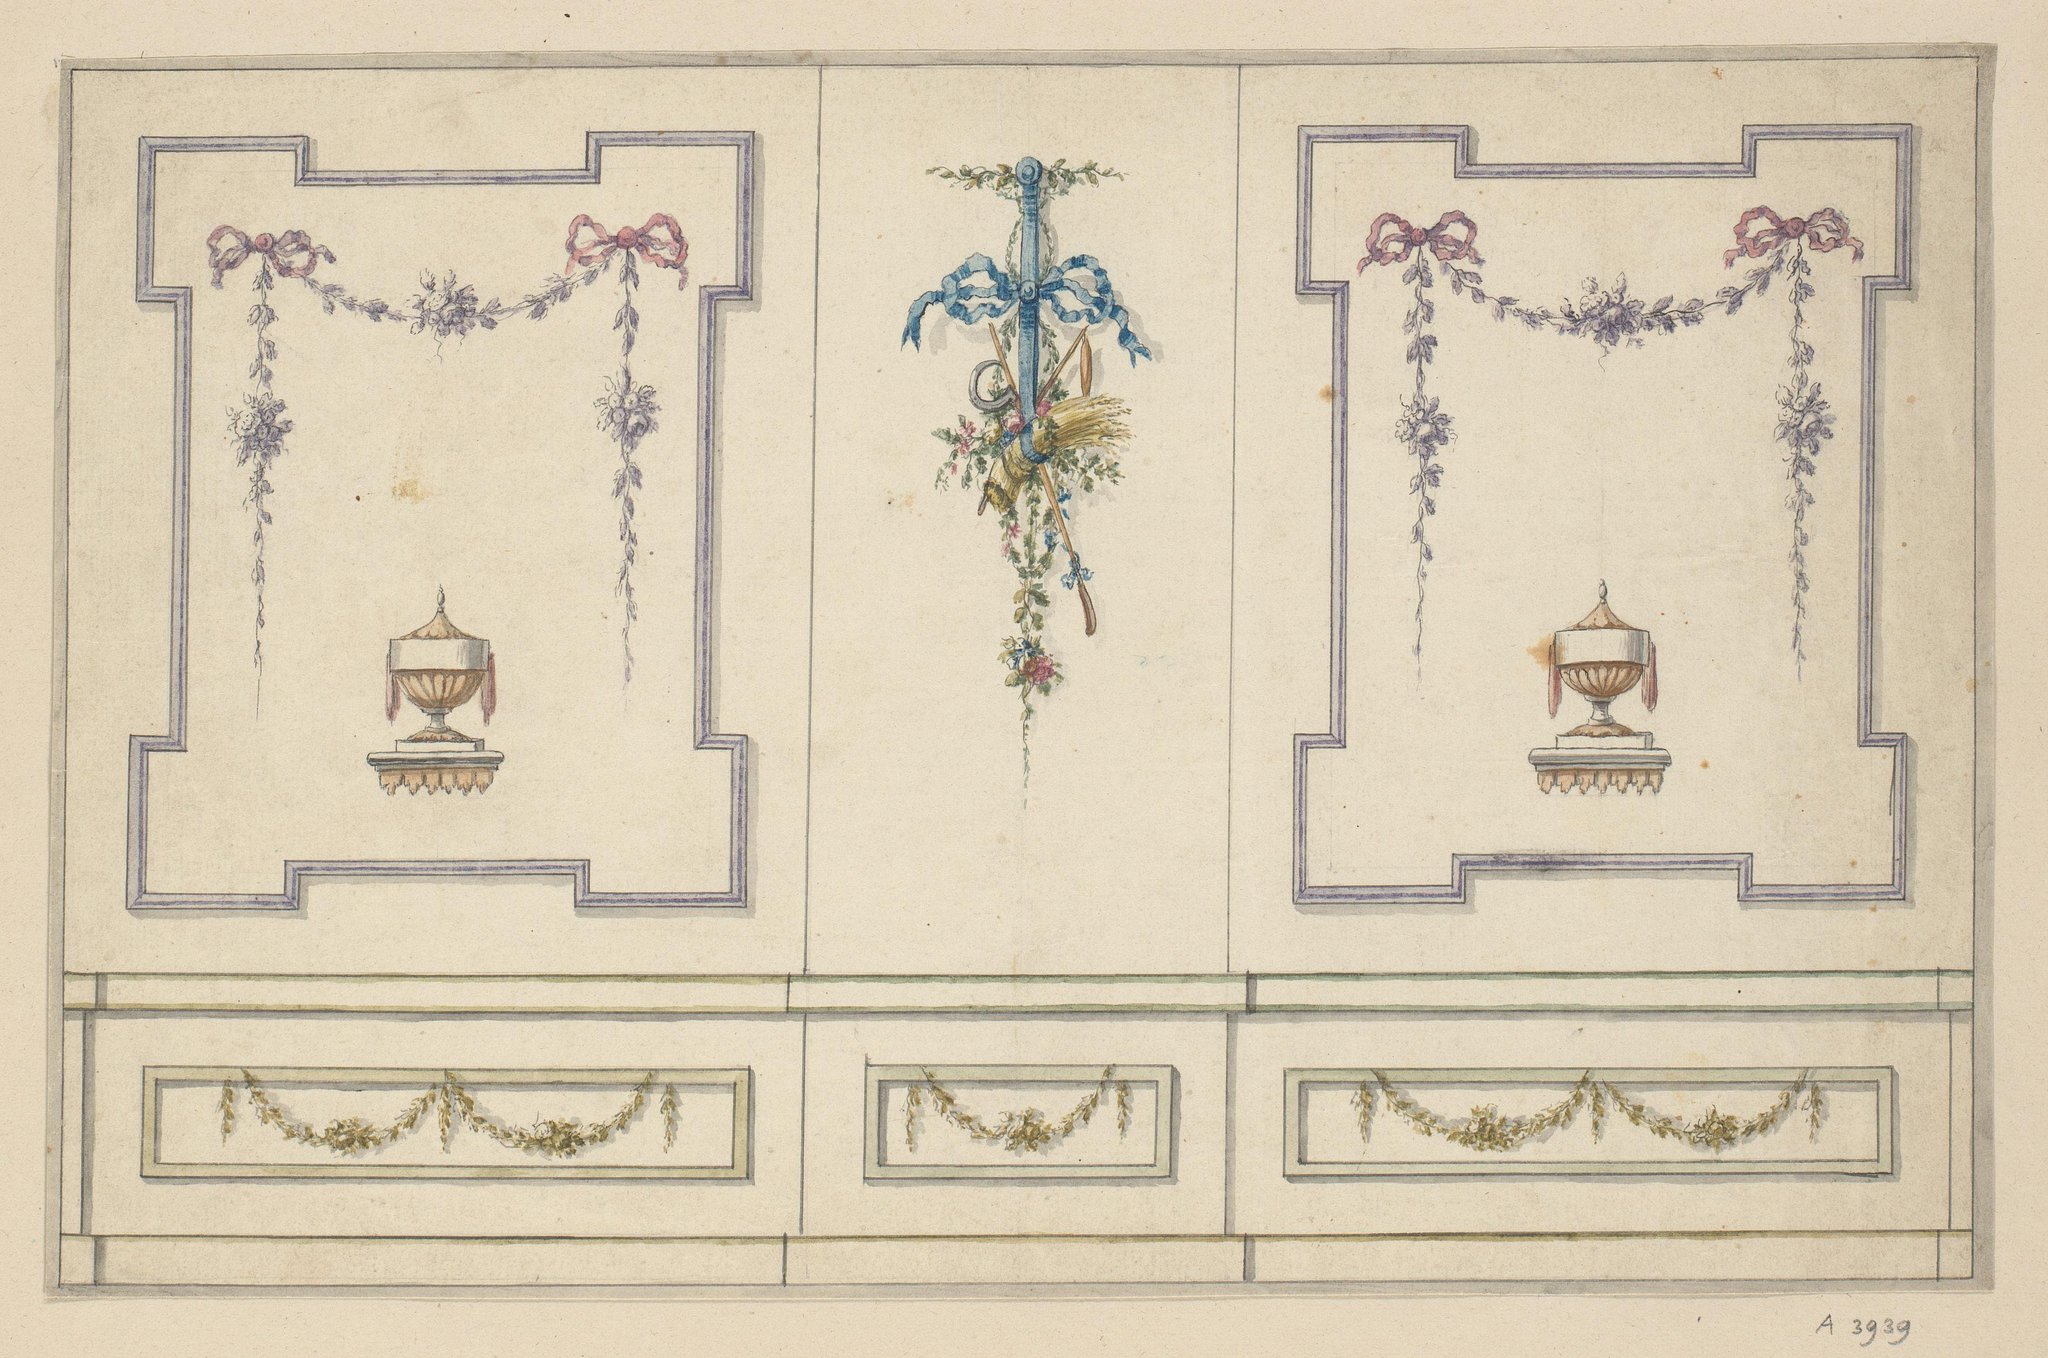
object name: drawing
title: Ontwerptekening voor een kamerwand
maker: abraham van strij (i)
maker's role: draughtsman, painter, print maker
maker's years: 1753-1826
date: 1763-1826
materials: paint, paper, pencil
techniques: brush, pen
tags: wall-covering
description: De tekeningen van Abraham van Strij zijn op een later moment ingevoegd in het album met tekeningen van Jurriaan Andriessen.